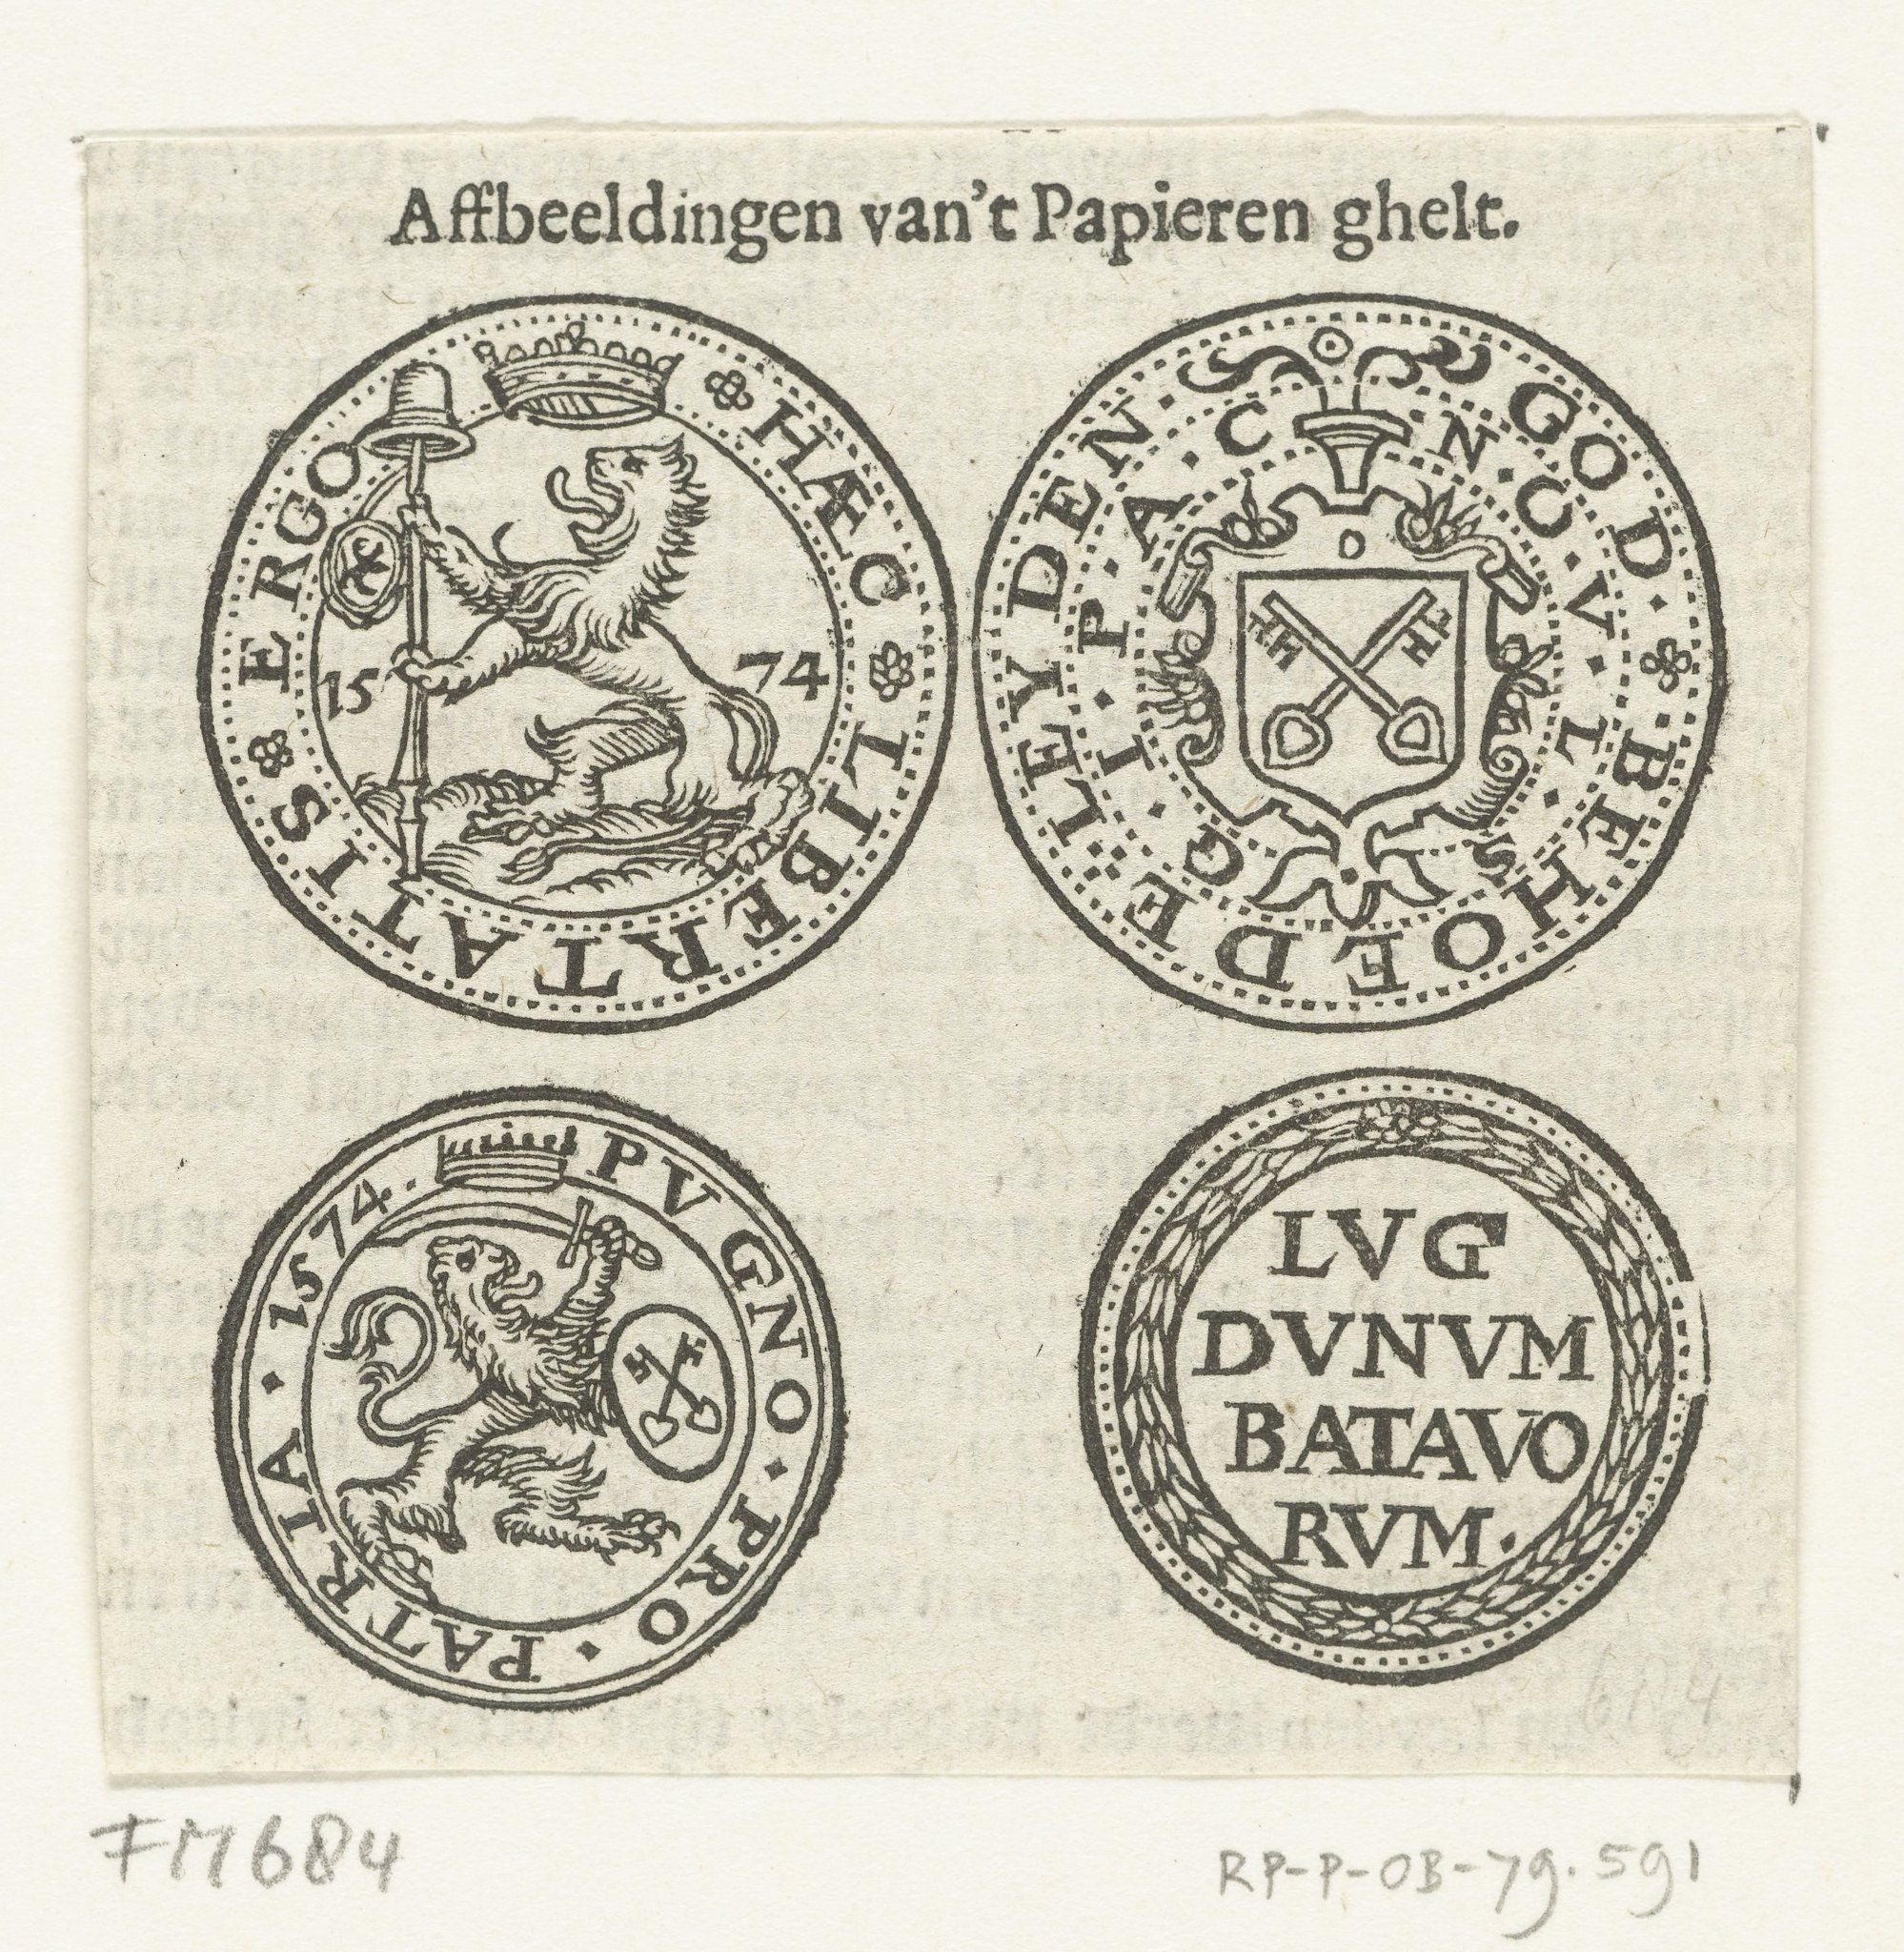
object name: historical object representation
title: Affbeeldingen van 't Papieren ghelt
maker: Anonymous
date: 1600-1699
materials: paper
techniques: letterpress printing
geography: netherlands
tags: coin, leiden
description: Twee papieren noodmunten uit het beleg van Leiden, 1574. Voorzijde leeuw met lans en vrijheidshoed en leeuw met zwaard en wapen van Leiden, keerzijde wapen van Leiden en opschrift in Latijn. Bedrukt op achterzijde met tekst in het Nederlands.